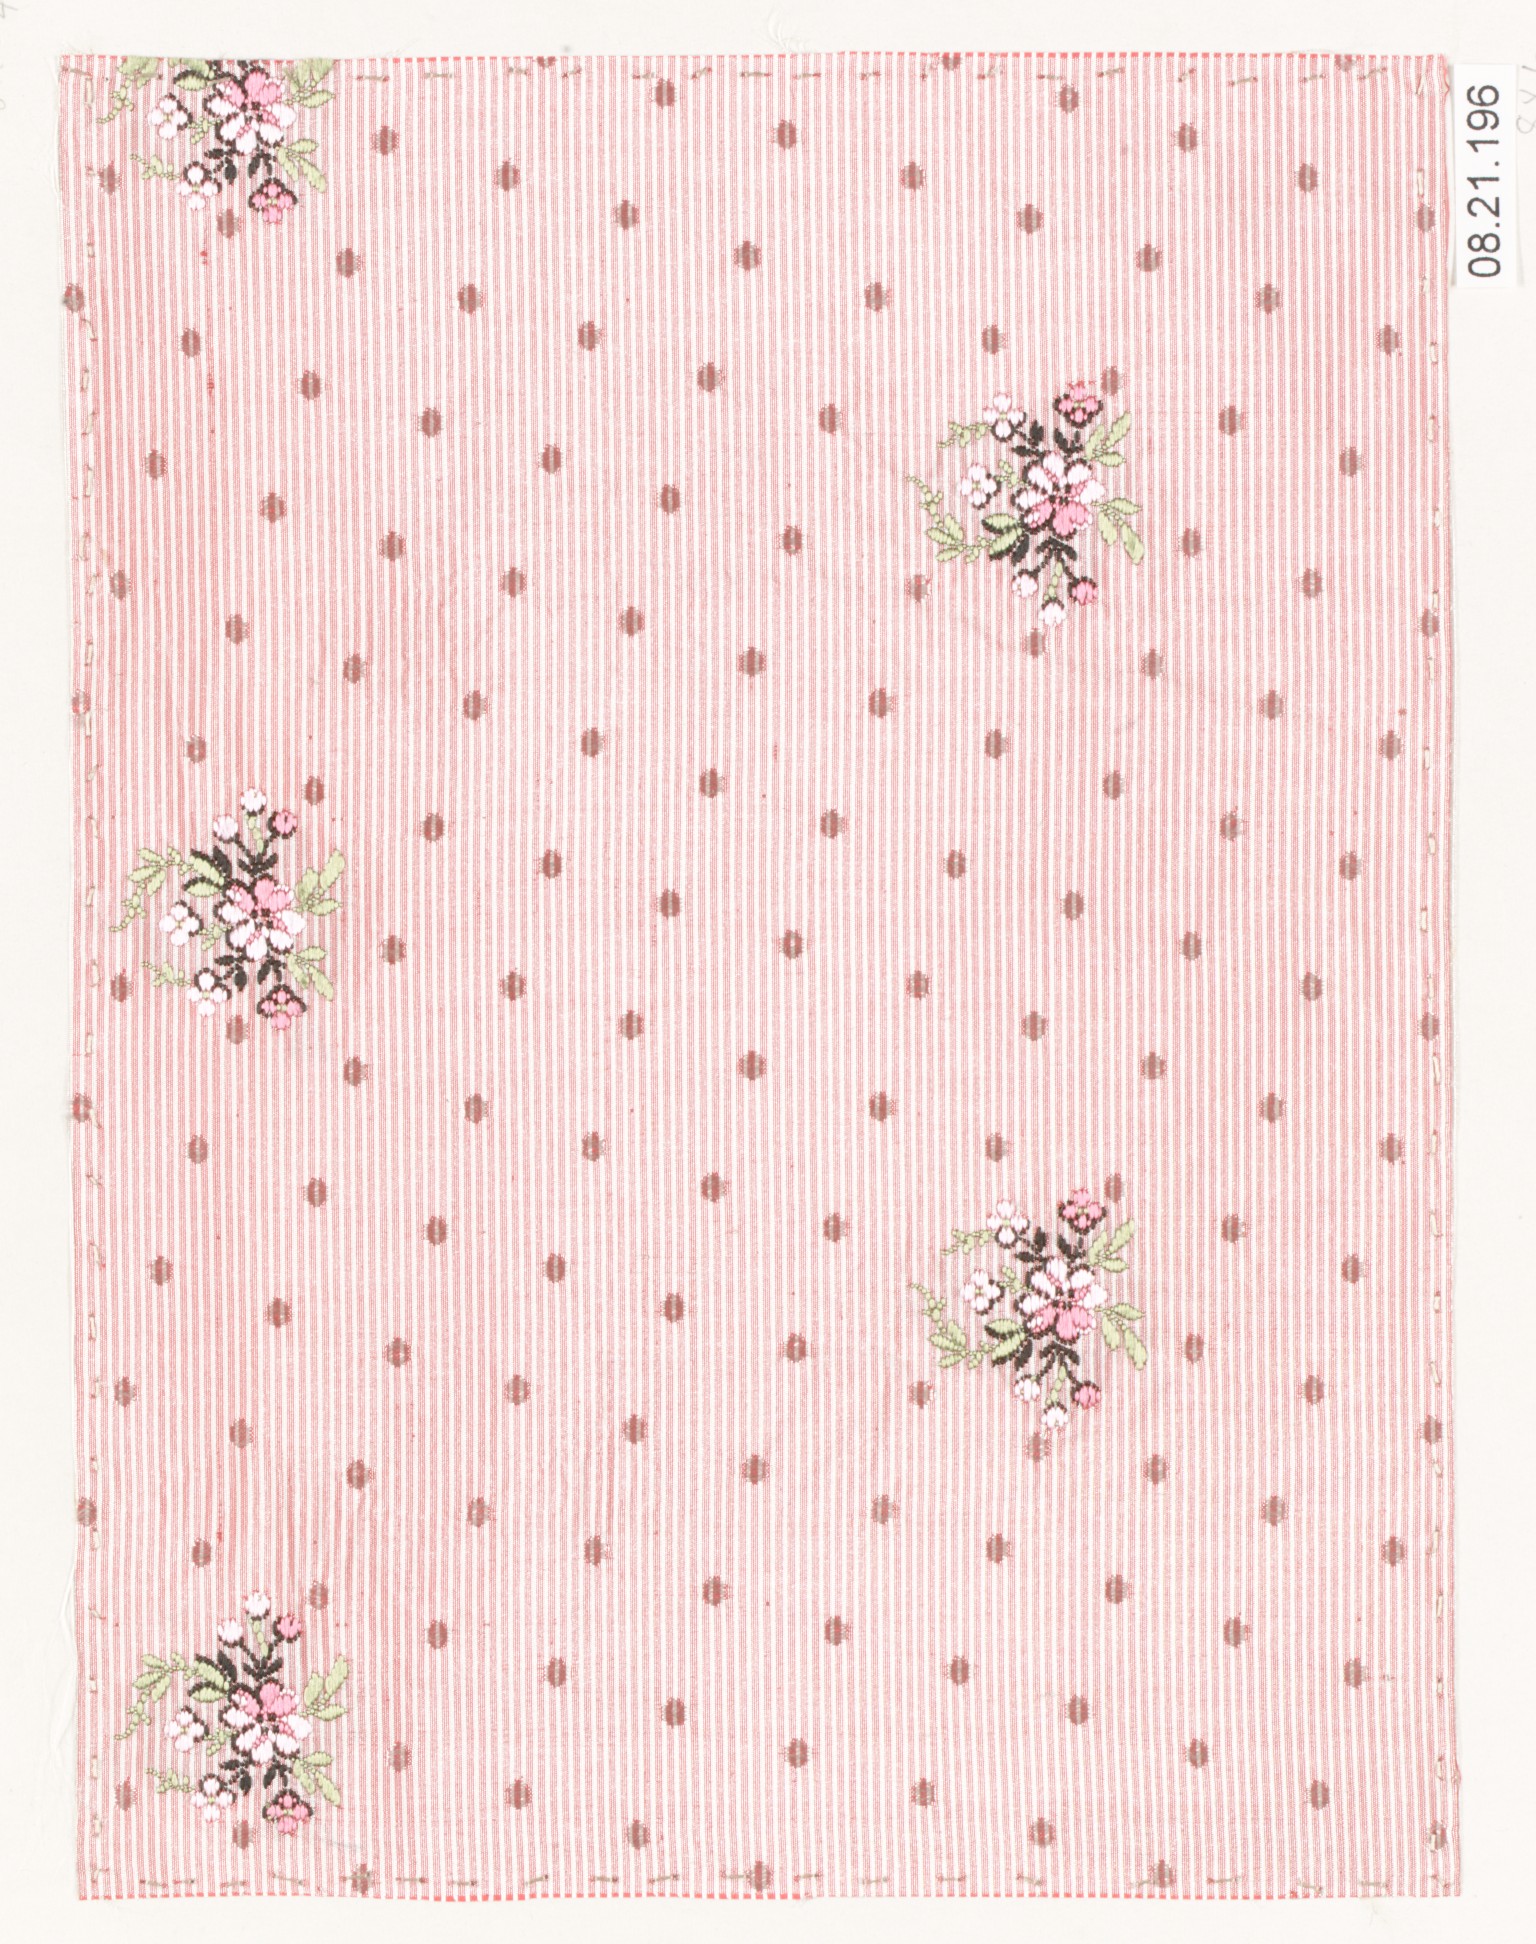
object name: textile sample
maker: Anonymous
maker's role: designer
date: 1900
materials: silk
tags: flowers